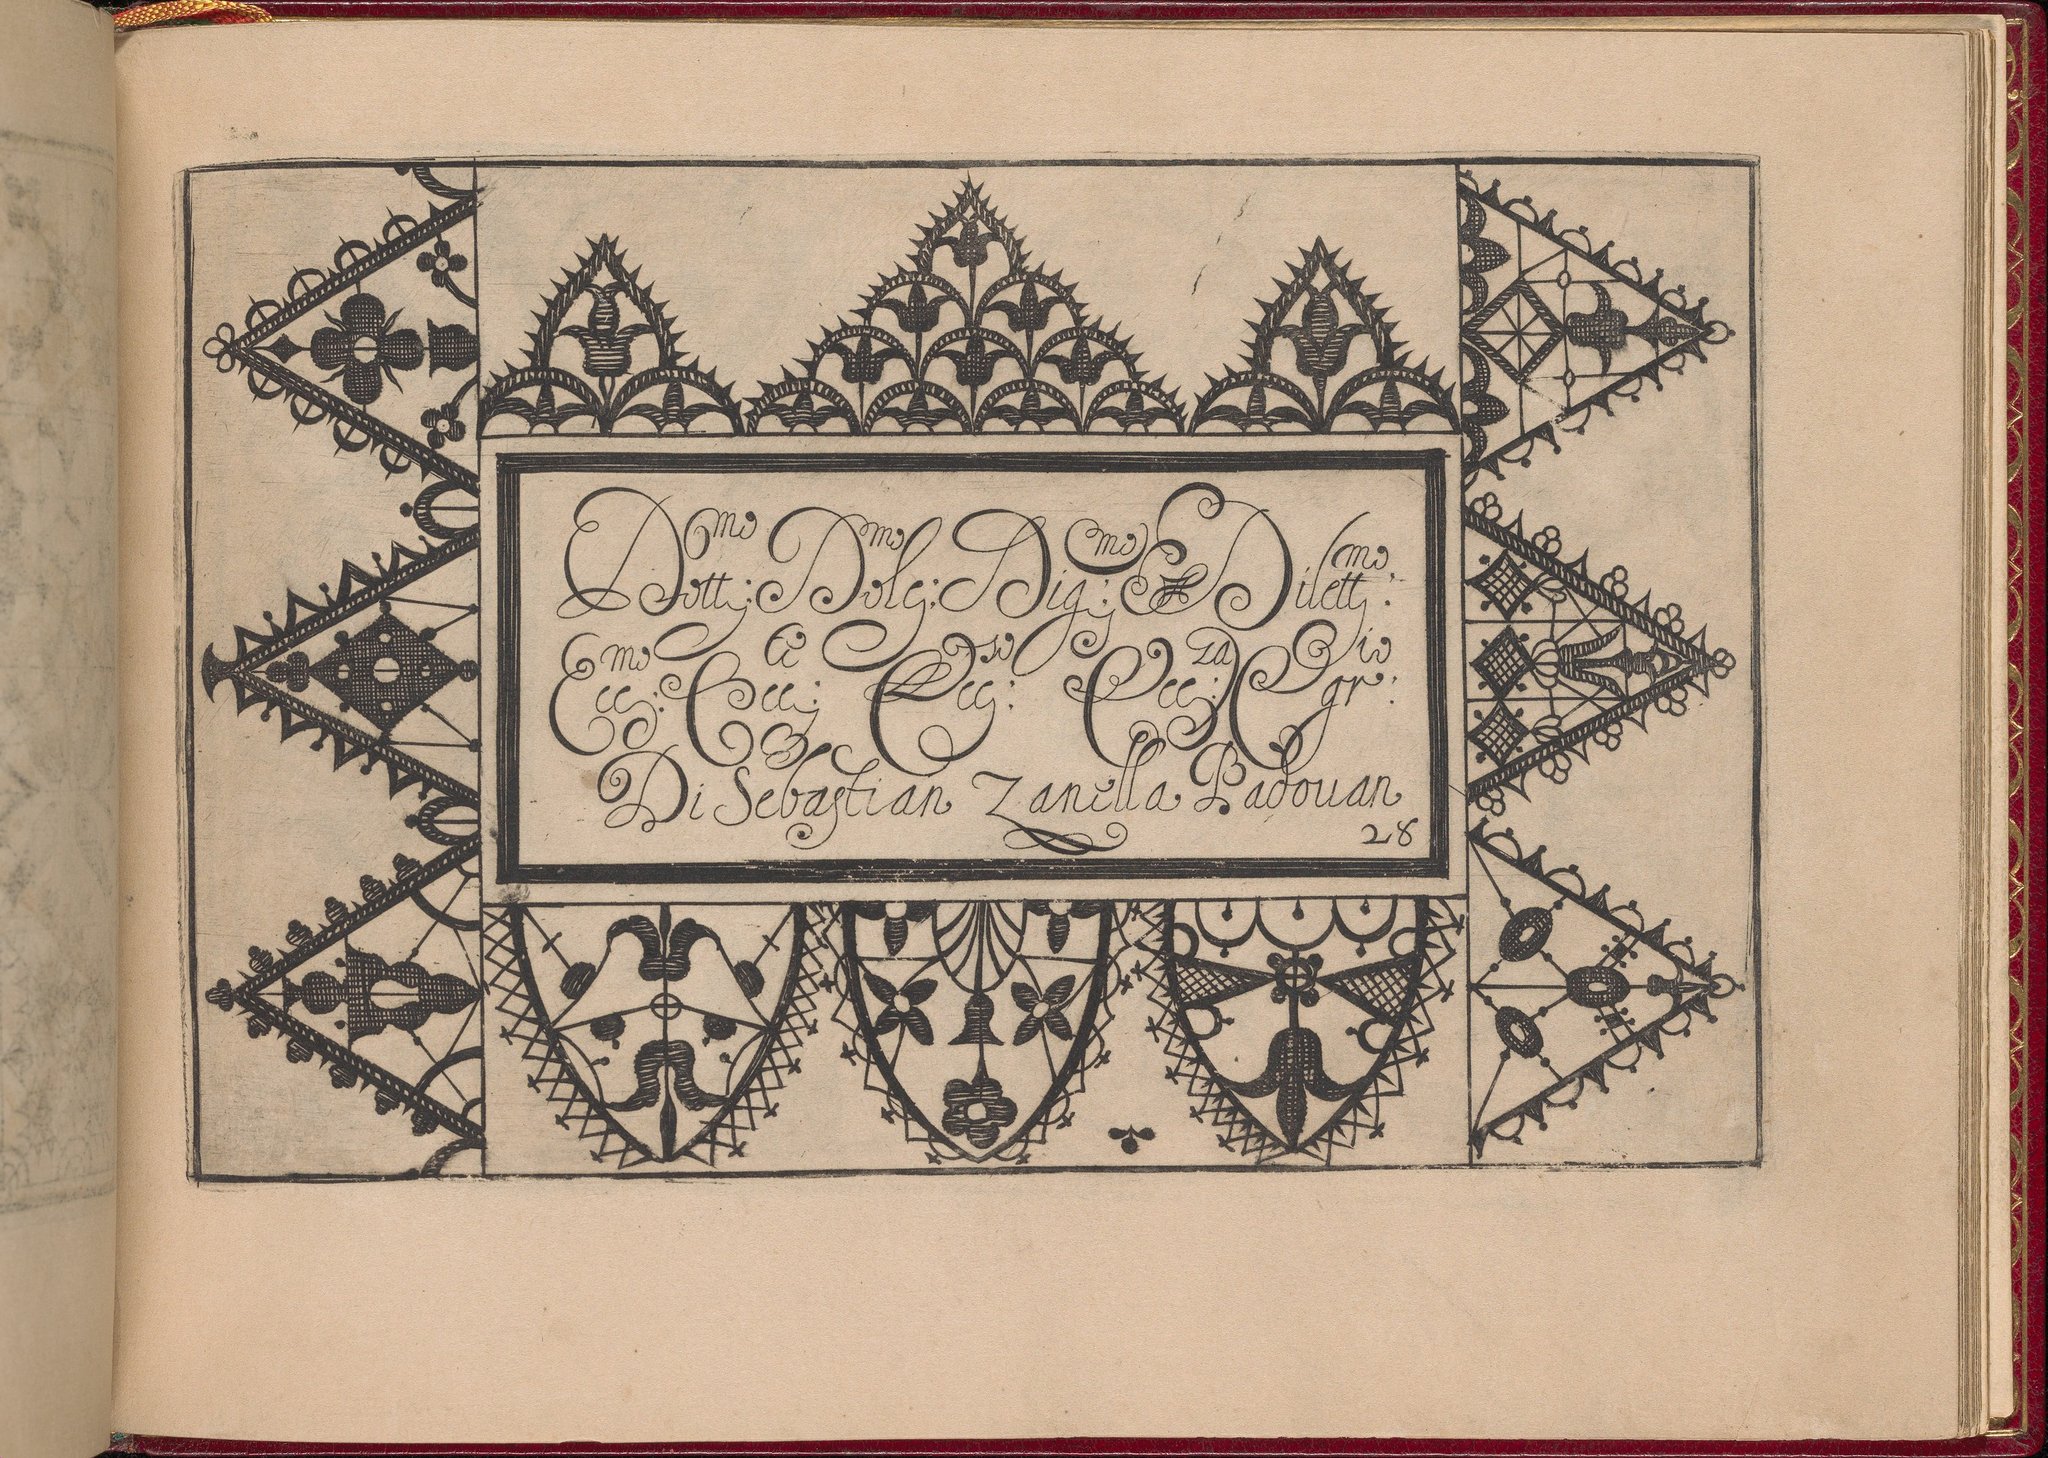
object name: book print ornament architecture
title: Ghirlanda: Di sei vaghi fiori scielti da piu famosi Giardini d'Italia, page 36 (recto)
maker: pietro paulo tozzi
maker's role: designer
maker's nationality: italian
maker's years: 1593-1628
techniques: drawing, etching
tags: ornament